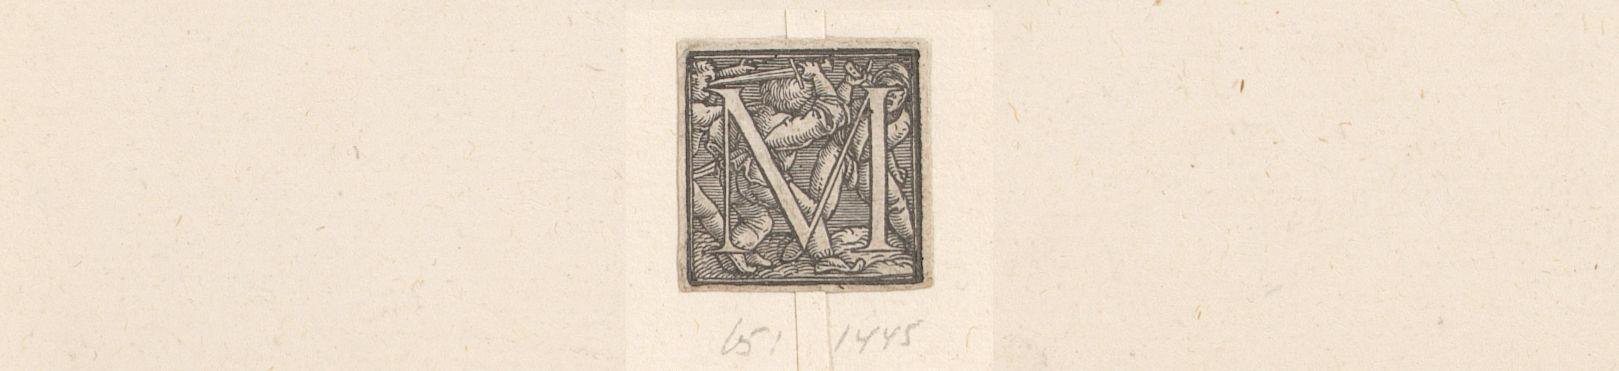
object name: album leaf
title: Latijns alfabet met boeren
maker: hans lützelburger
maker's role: print maker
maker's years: -1526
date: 1525-1526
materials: paper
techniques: woodcut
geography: basel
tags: initial, farmers, hacking and thrusting weapons: sword